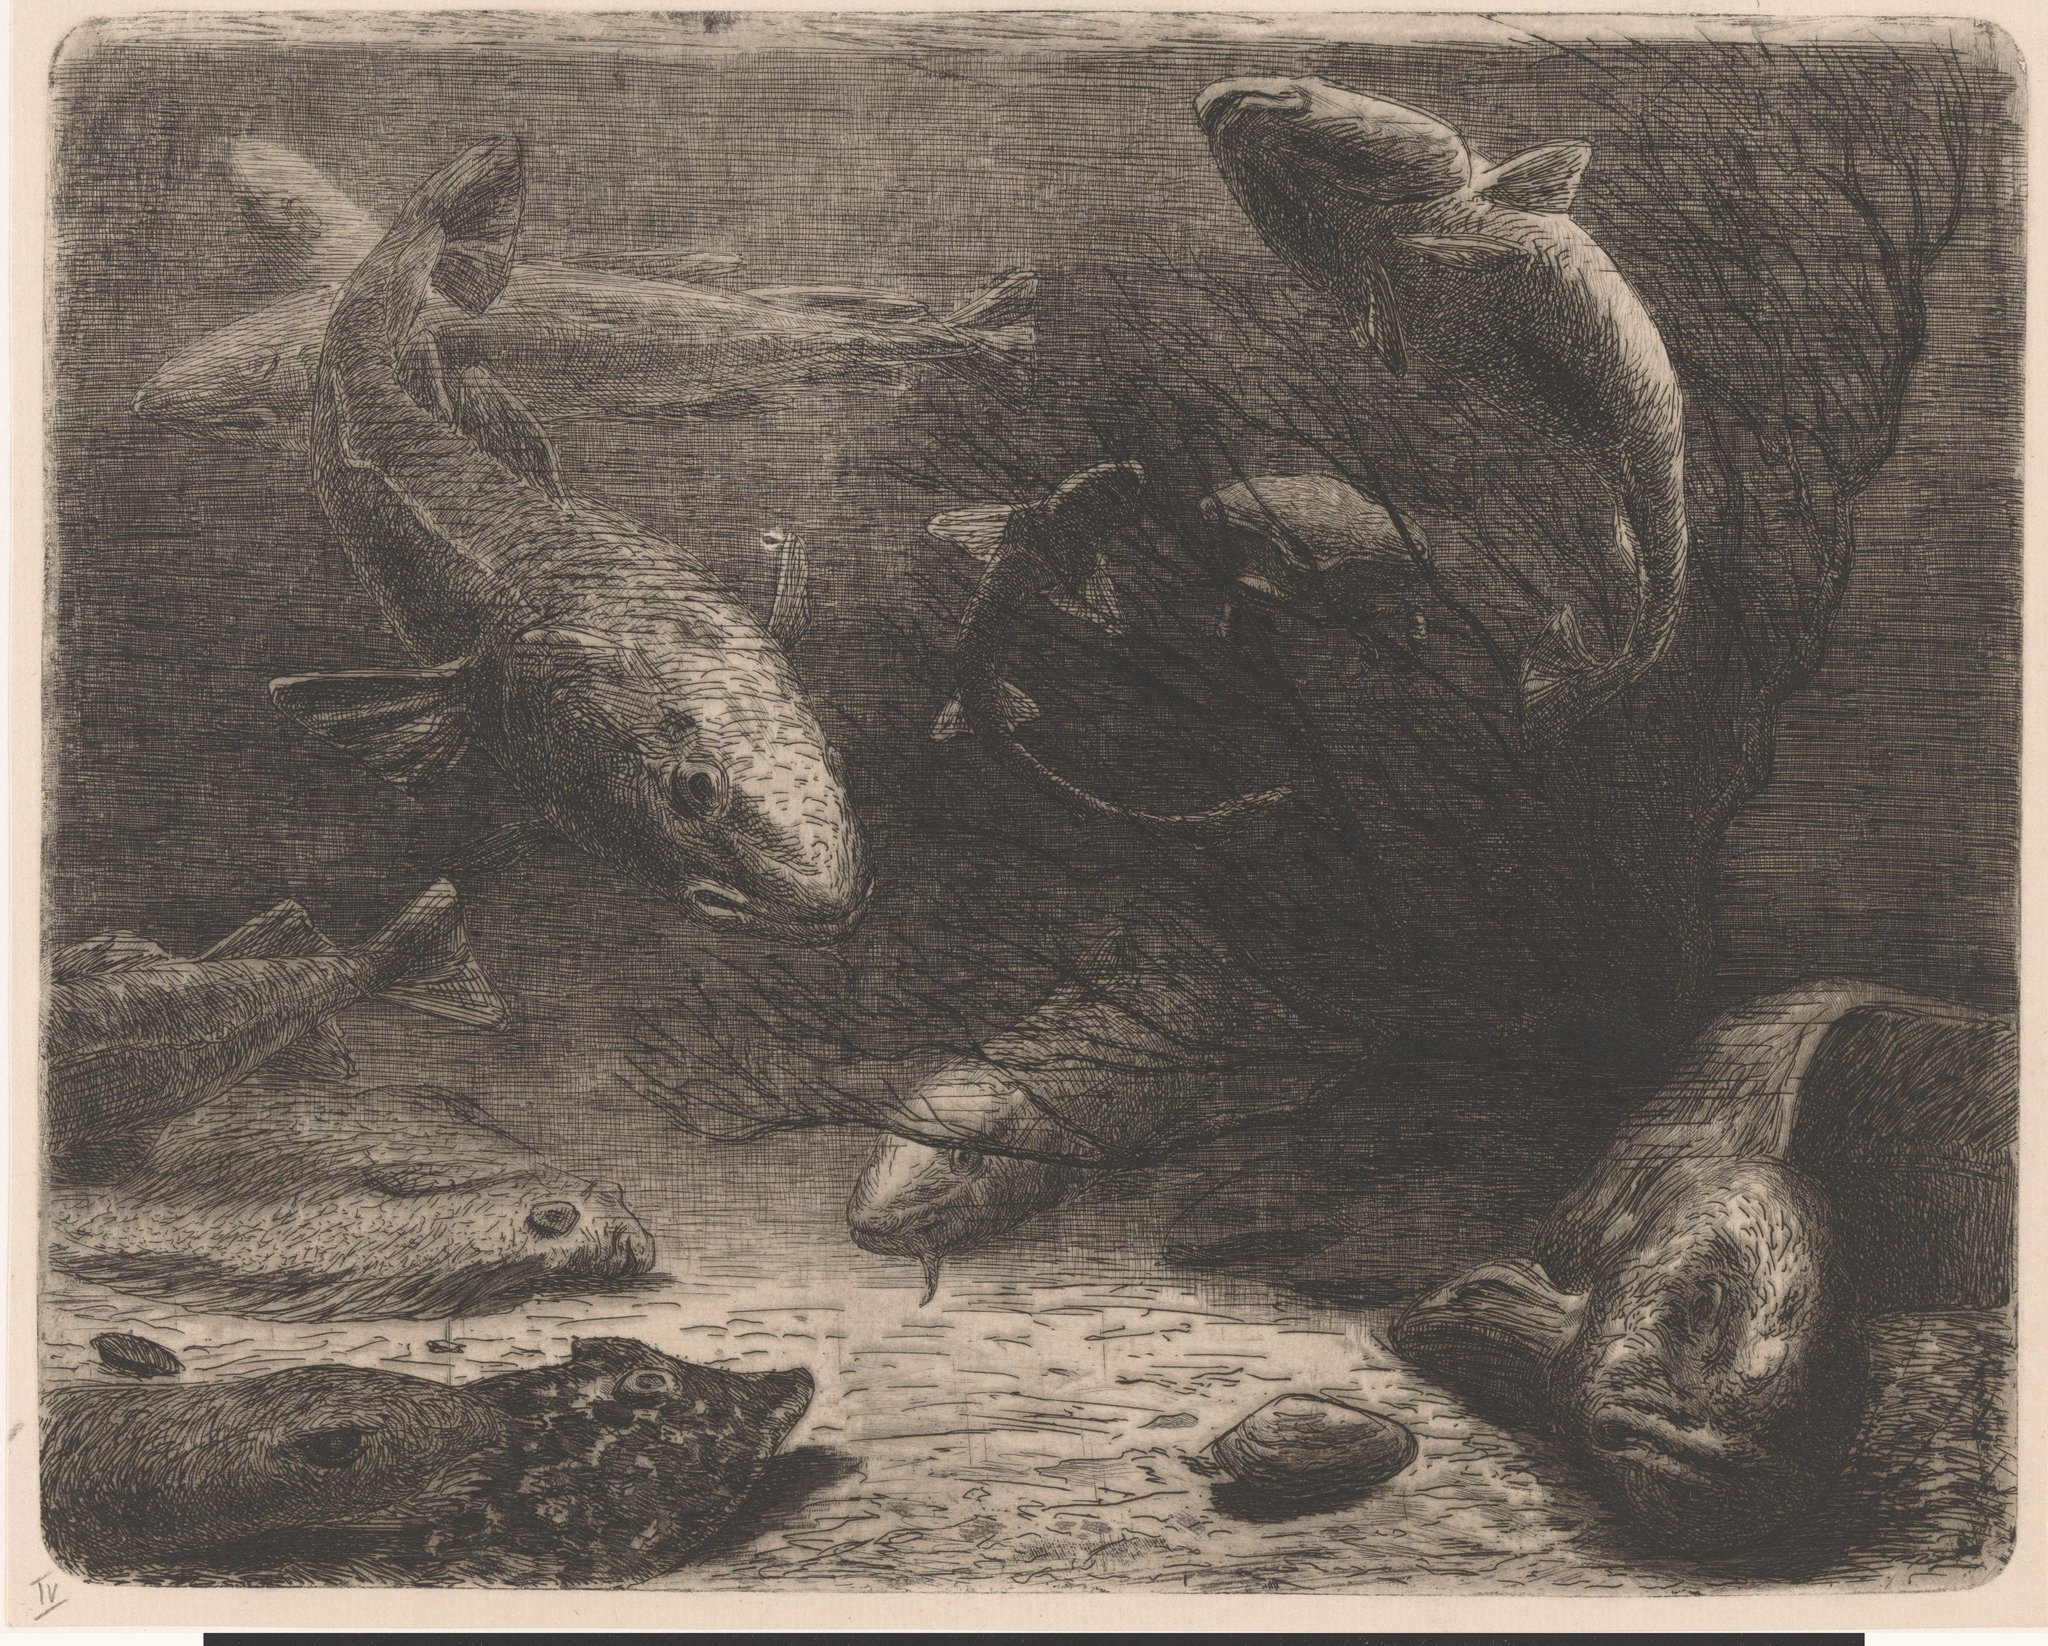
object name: print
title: Aquarium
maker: august le gras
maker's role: draughtsman, print maker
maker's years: 1864-1915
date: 1887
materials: paper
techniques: drypoint, etching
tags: aquarium, crustaceans: crab, bony fishes: plaice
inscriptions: collector's mark: Lugt 2228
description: Aquarium met elf vissen en een krab. Links liggen twee schollen op de bodem. Rechts een waterplant.